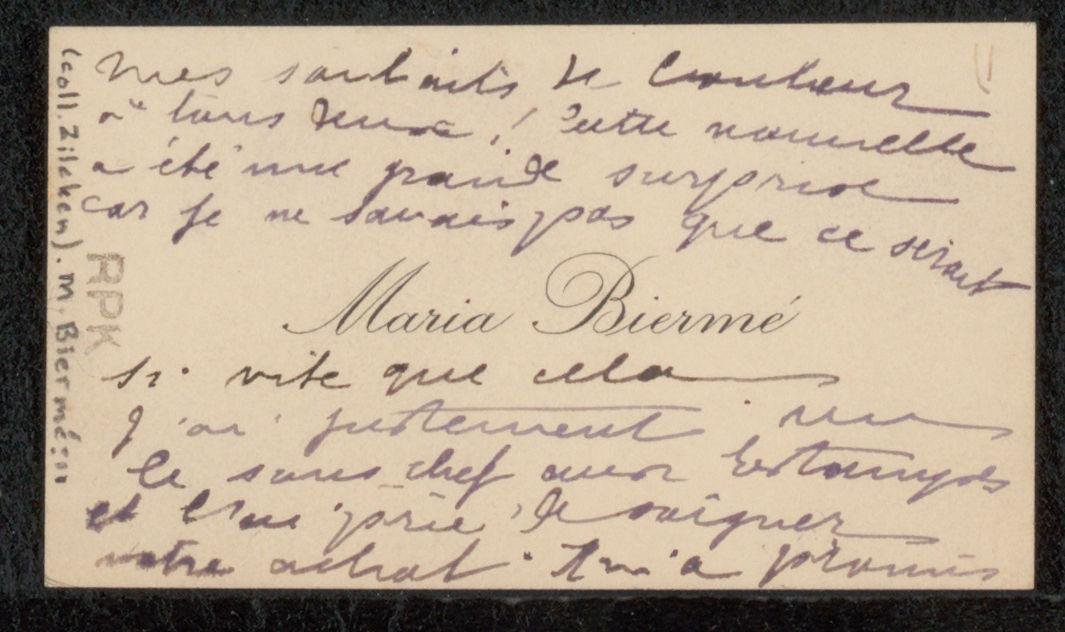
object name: visiting card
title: Visitekaartje aan Philip Zilcken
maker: maria biermé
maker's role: dichter, schrijver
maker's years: 1863-1932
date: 1873-1932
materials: cardboard, ink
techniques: pen, printing, writing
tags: painter, draughtsman, philip zilcken, italy, brussels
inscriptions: collector's mark: ‘RPK’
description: Twee beschreven visitekaartjes en een fragment van een beschreven envelop.